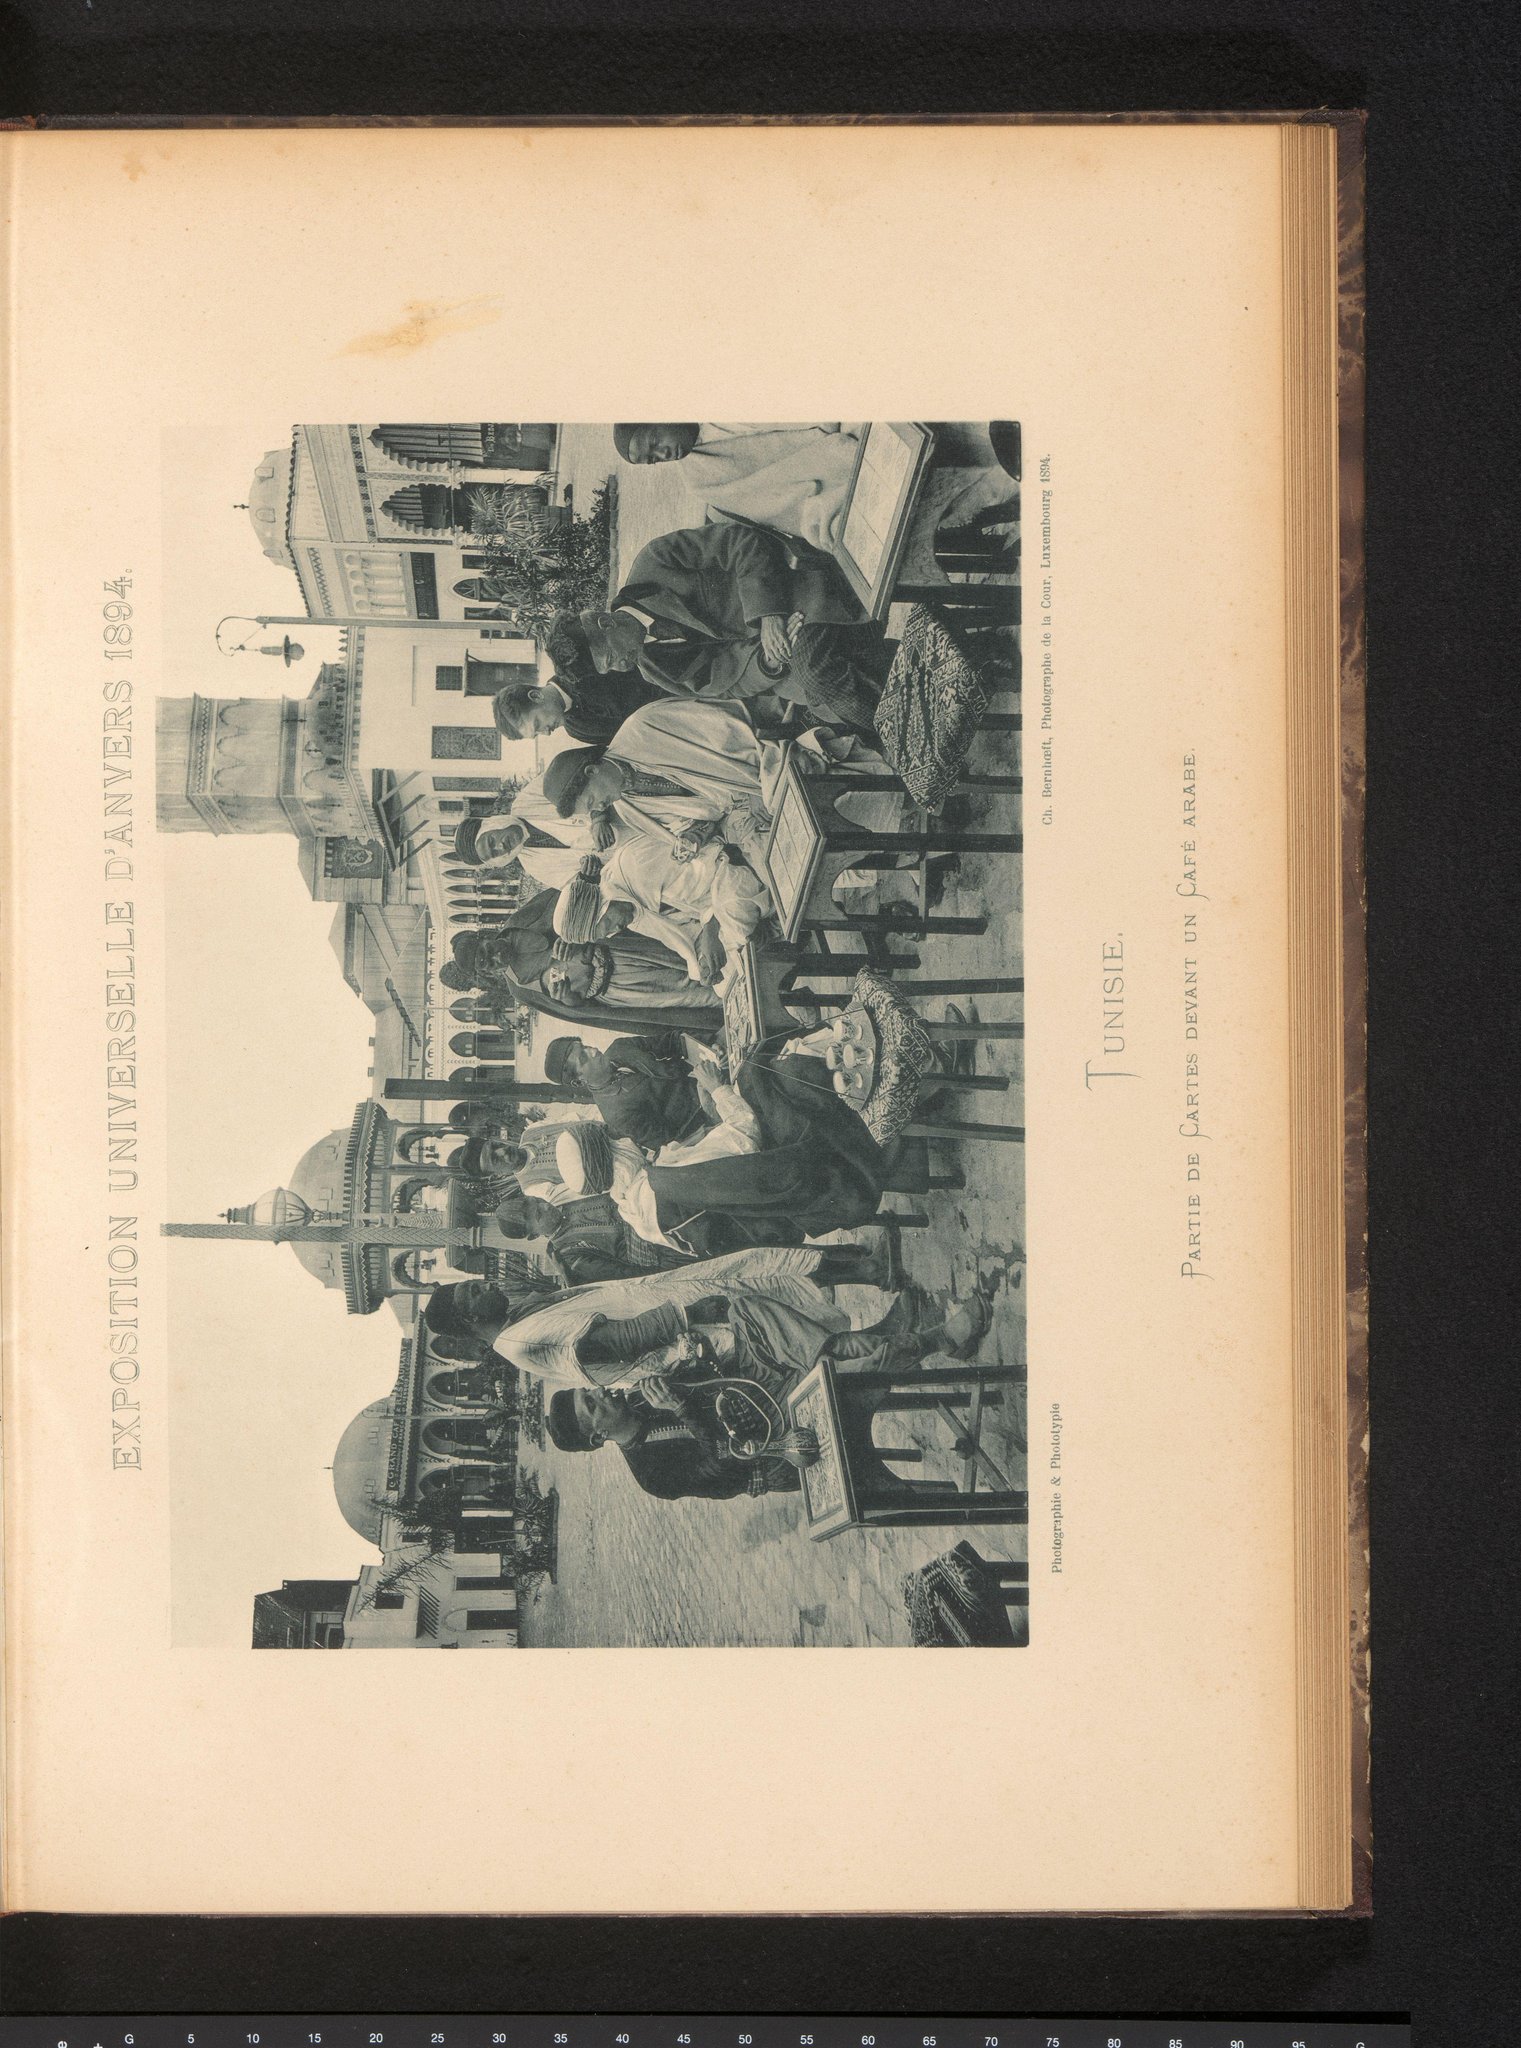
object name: page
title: Groep mannen speelt een kaartspel op een plein in het Tunesische deel van de Wereldtentoonstelling van Antwerpen in 1894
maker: charles bernhoeft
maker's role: publisher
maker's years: 1859-1933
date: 1894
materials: paper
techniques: photograph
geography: antwerp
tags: square, place, circus, etc., world fair, world exhibition, adult man, card games, antwerp